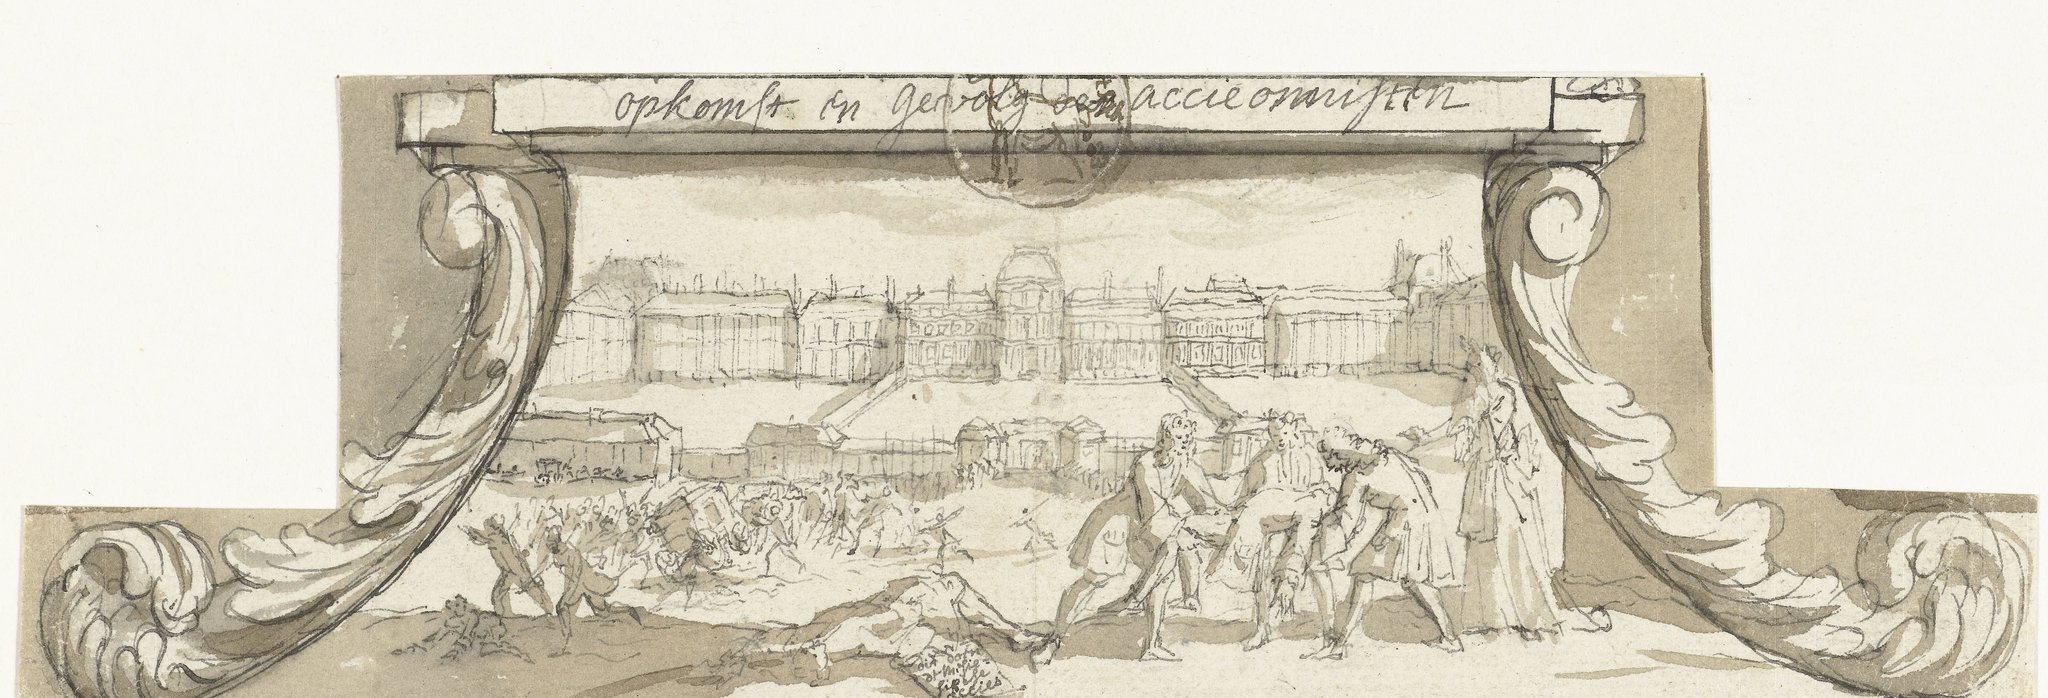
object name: drawing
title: opkomst en gevolg der accieonnisten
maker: Anonymous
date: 1720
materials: paper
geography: northern netherlands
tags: financial panic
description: Uitgeknipt blad met het getekende ontwerp voor de voorstelling van de paniek in de Parijse Tuilerieën, onderdeel van de prent met de Op- en Ondergang van de Actionisten. Ontwerp voor een onderdeel van prent 7 in de serie Het Groote Tafereel der Dwaasheid met spotprenten op de Windhandel of Actiehandel van 1720. Ontwerp voor een prent.